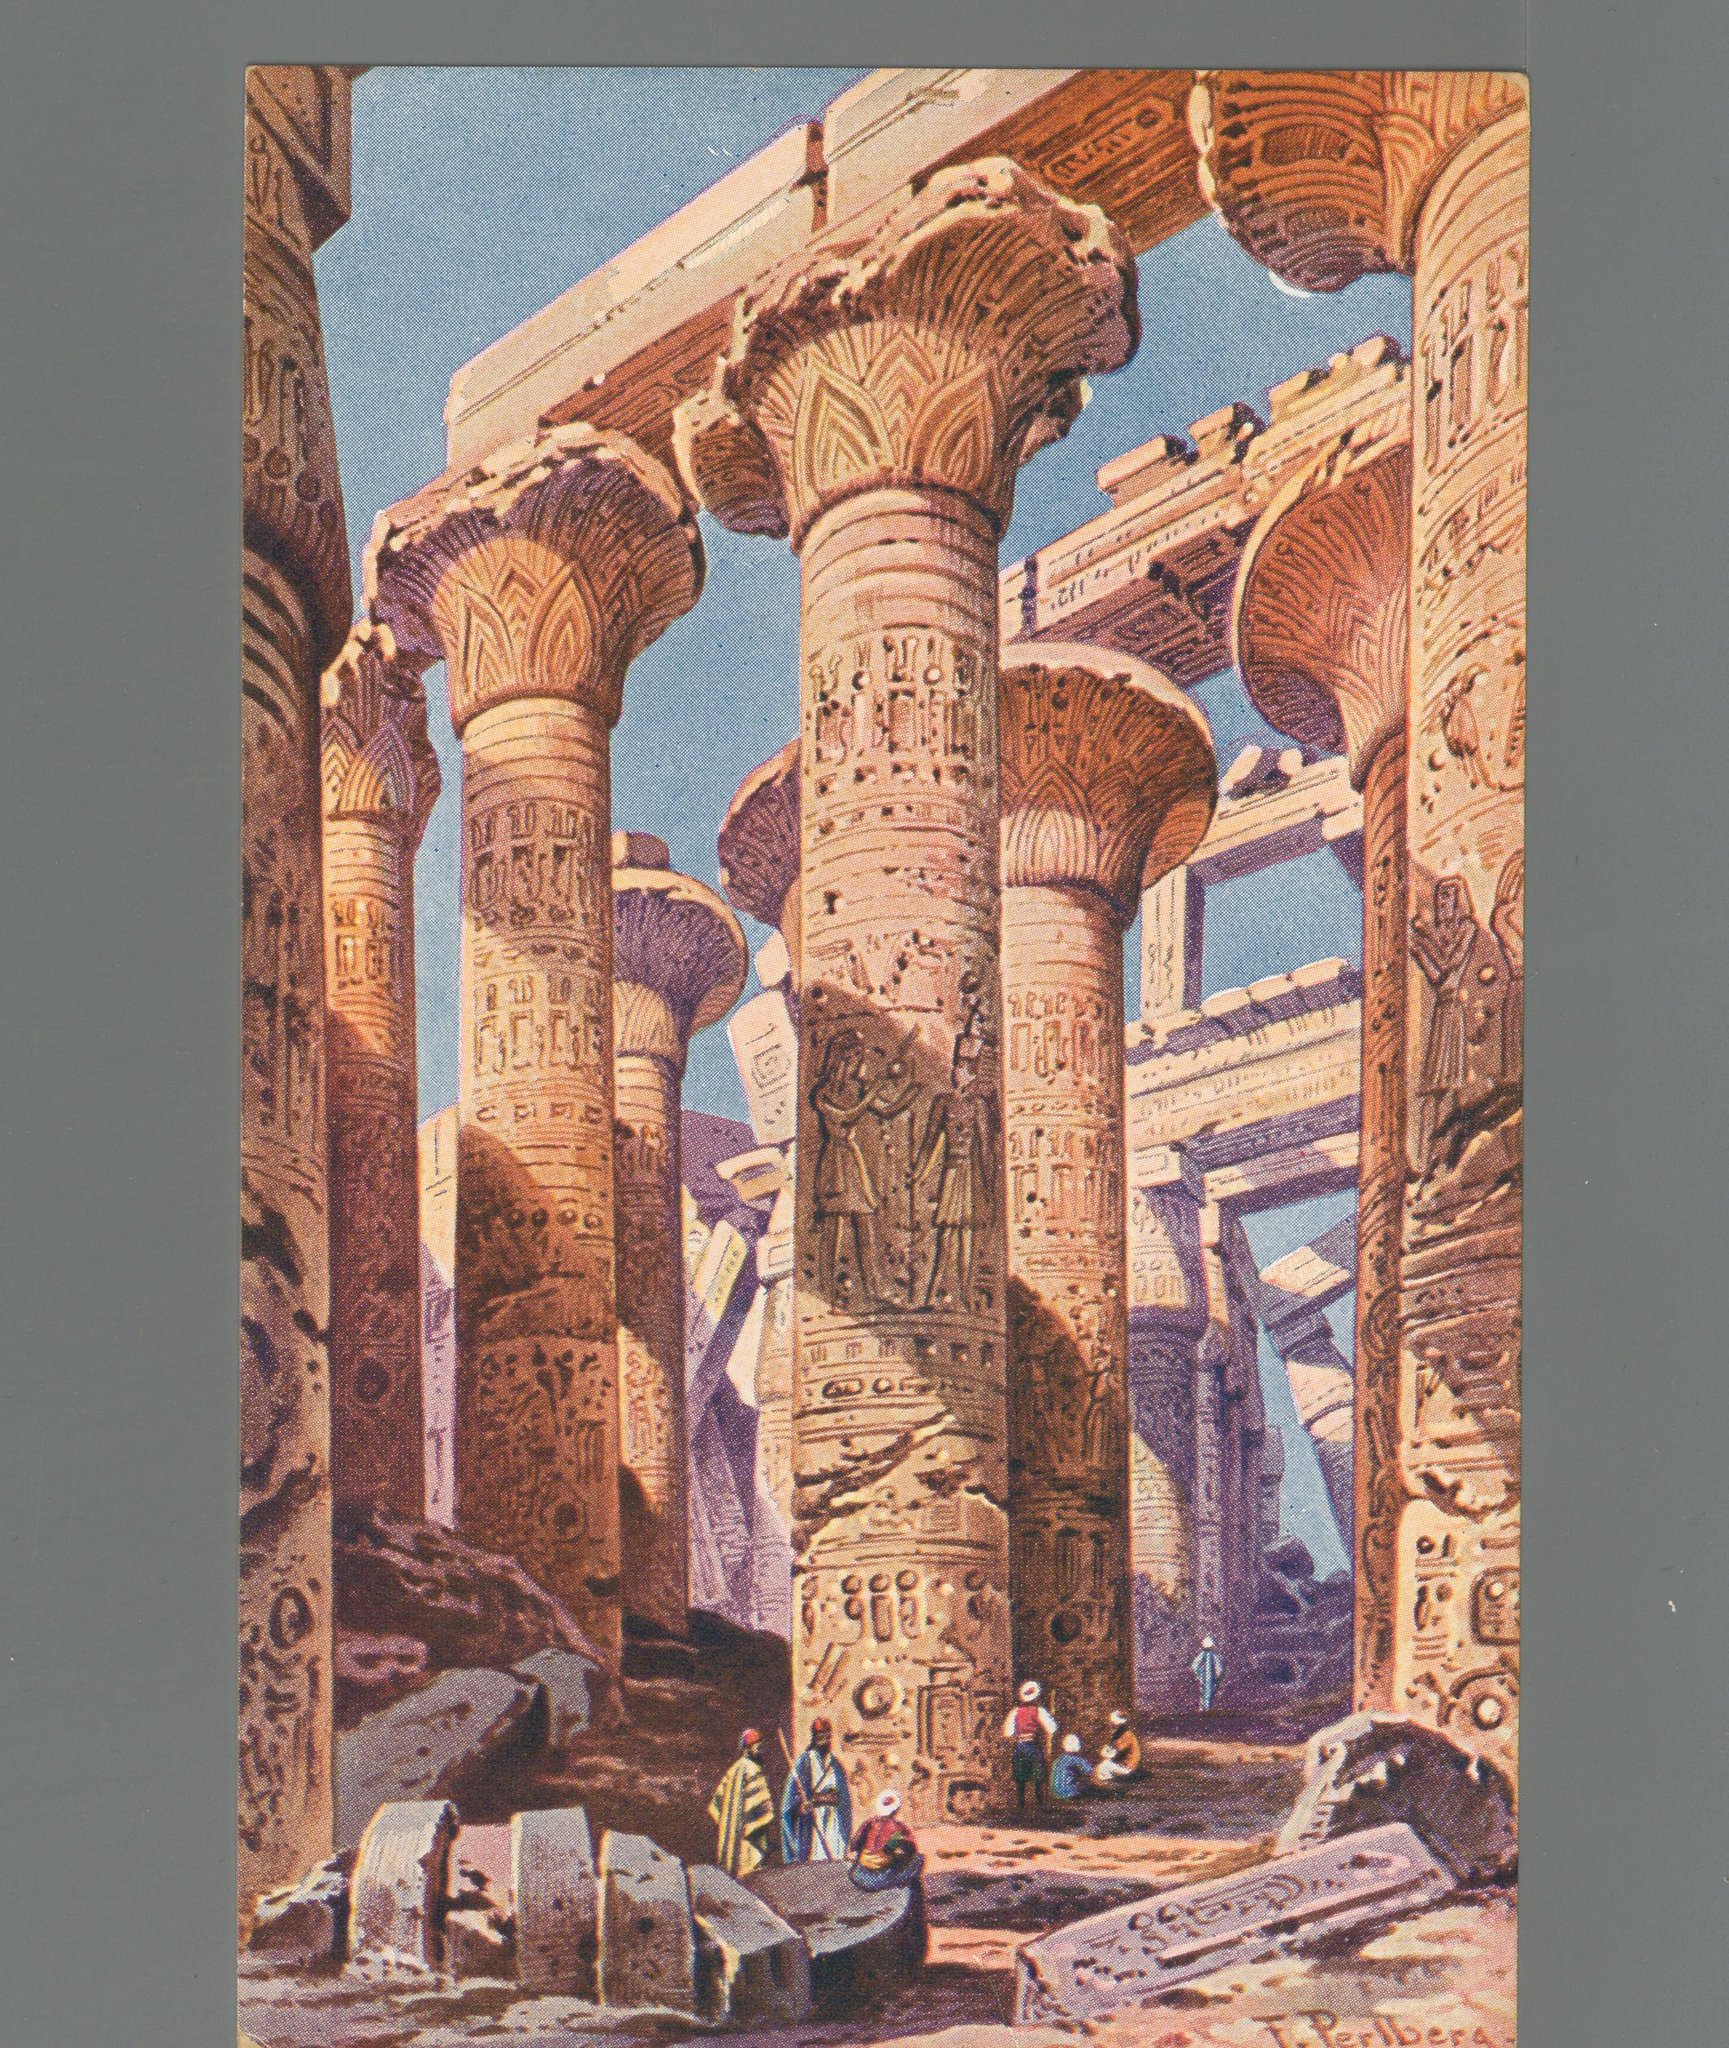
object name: ansichtkaart, prentbriefkaart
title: Temple à Karnak / Temple at Karnak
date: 1907-1930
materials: cardboard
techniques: color autotype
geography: dresden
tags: temple, shrine ~ egyptian religion